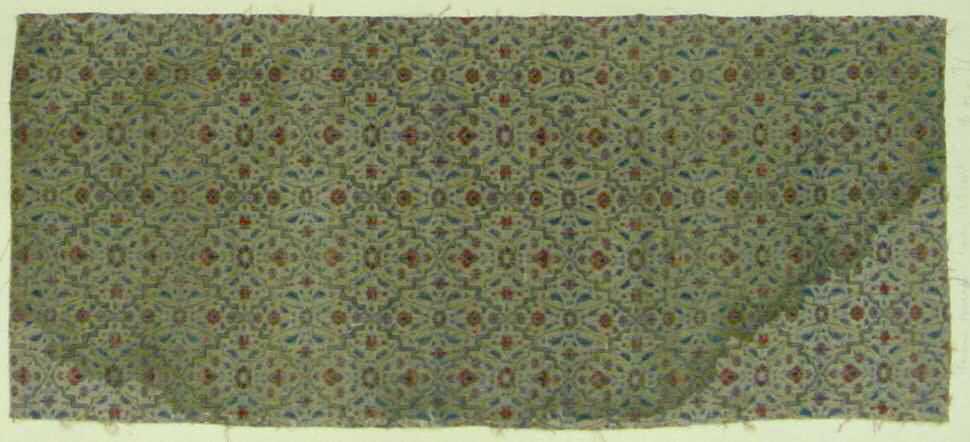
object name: textile fragment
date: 1701-1733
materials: metal thread, silk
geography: iran